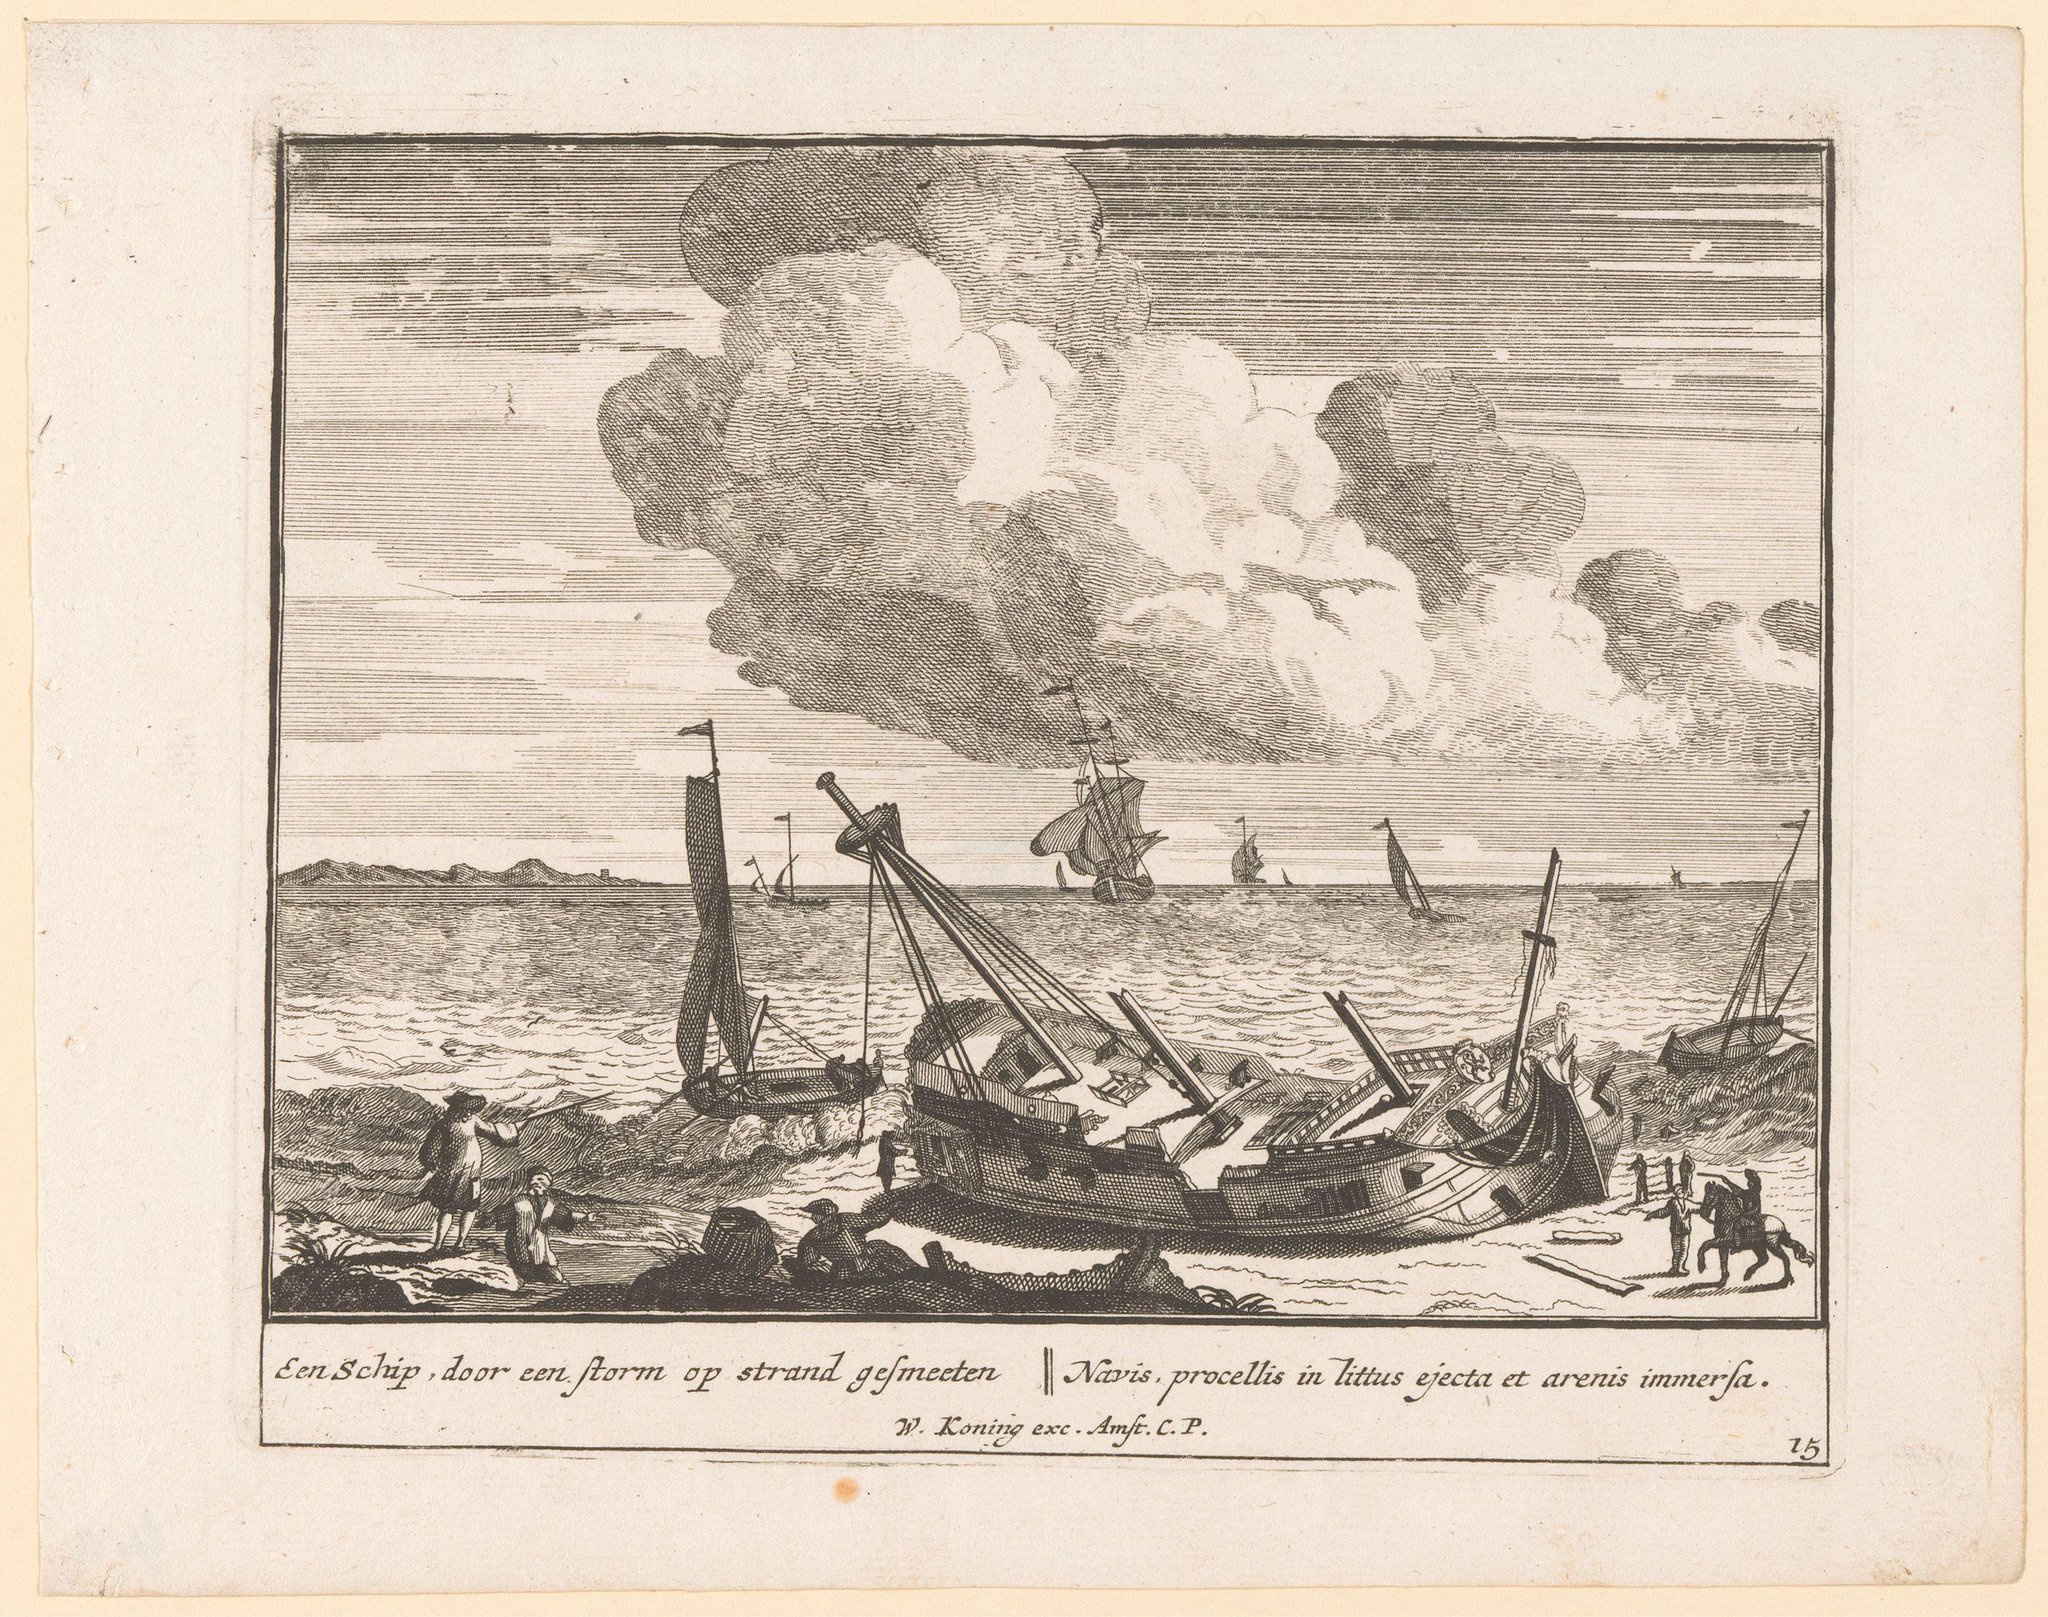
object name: print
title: Navigiorum Aedificatio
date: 1717-1732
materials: paper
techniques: engraving, etching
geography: amsterdam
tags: wreck ashore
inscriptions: collector's mark: Lugt 2228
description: Maakt deel uit van een zestiendelige serie met verschillende schepen in aanbouw en enkele ongelukken, getiteld 'Navigiorum Aedificatio' naar prenten door Siewert van der Meulen, uitgegeven door Isaac Greve en Wilhelmus Koning.